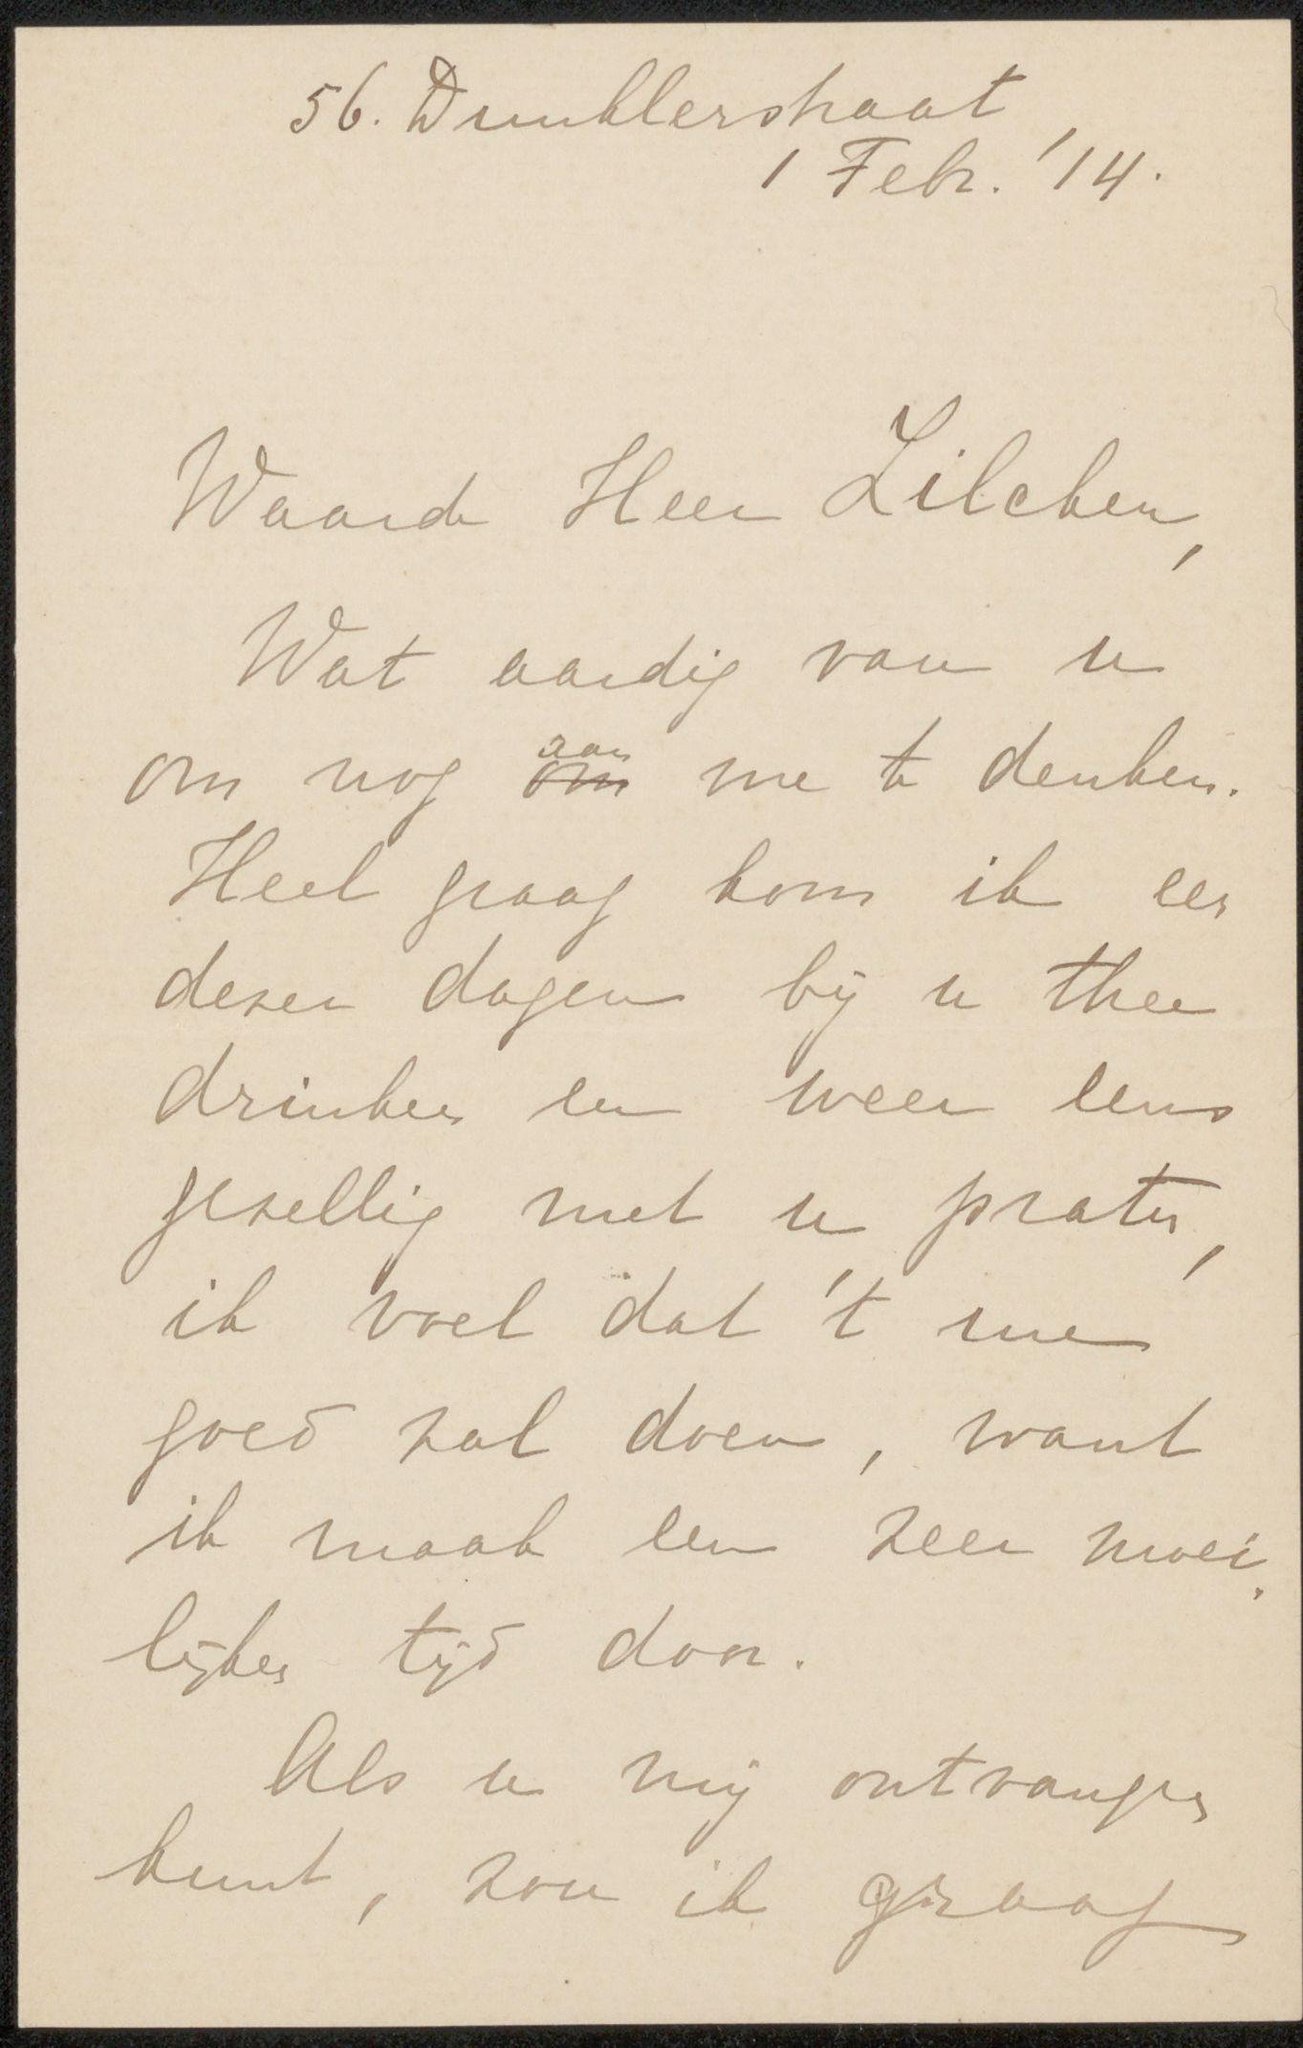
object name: letter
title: Brief aan Philip Zilcken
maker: fenna de meyier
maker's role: onderwijzer, schrijver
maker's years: 1874-1943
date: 1914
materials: ink, paper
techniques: pen, writing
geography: the hague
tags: henriette wilhelmina van baak, painter, draughtsman, philip zilcken, passions, emotions, affections, diseases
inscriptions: collector's mark: ‘RPK’